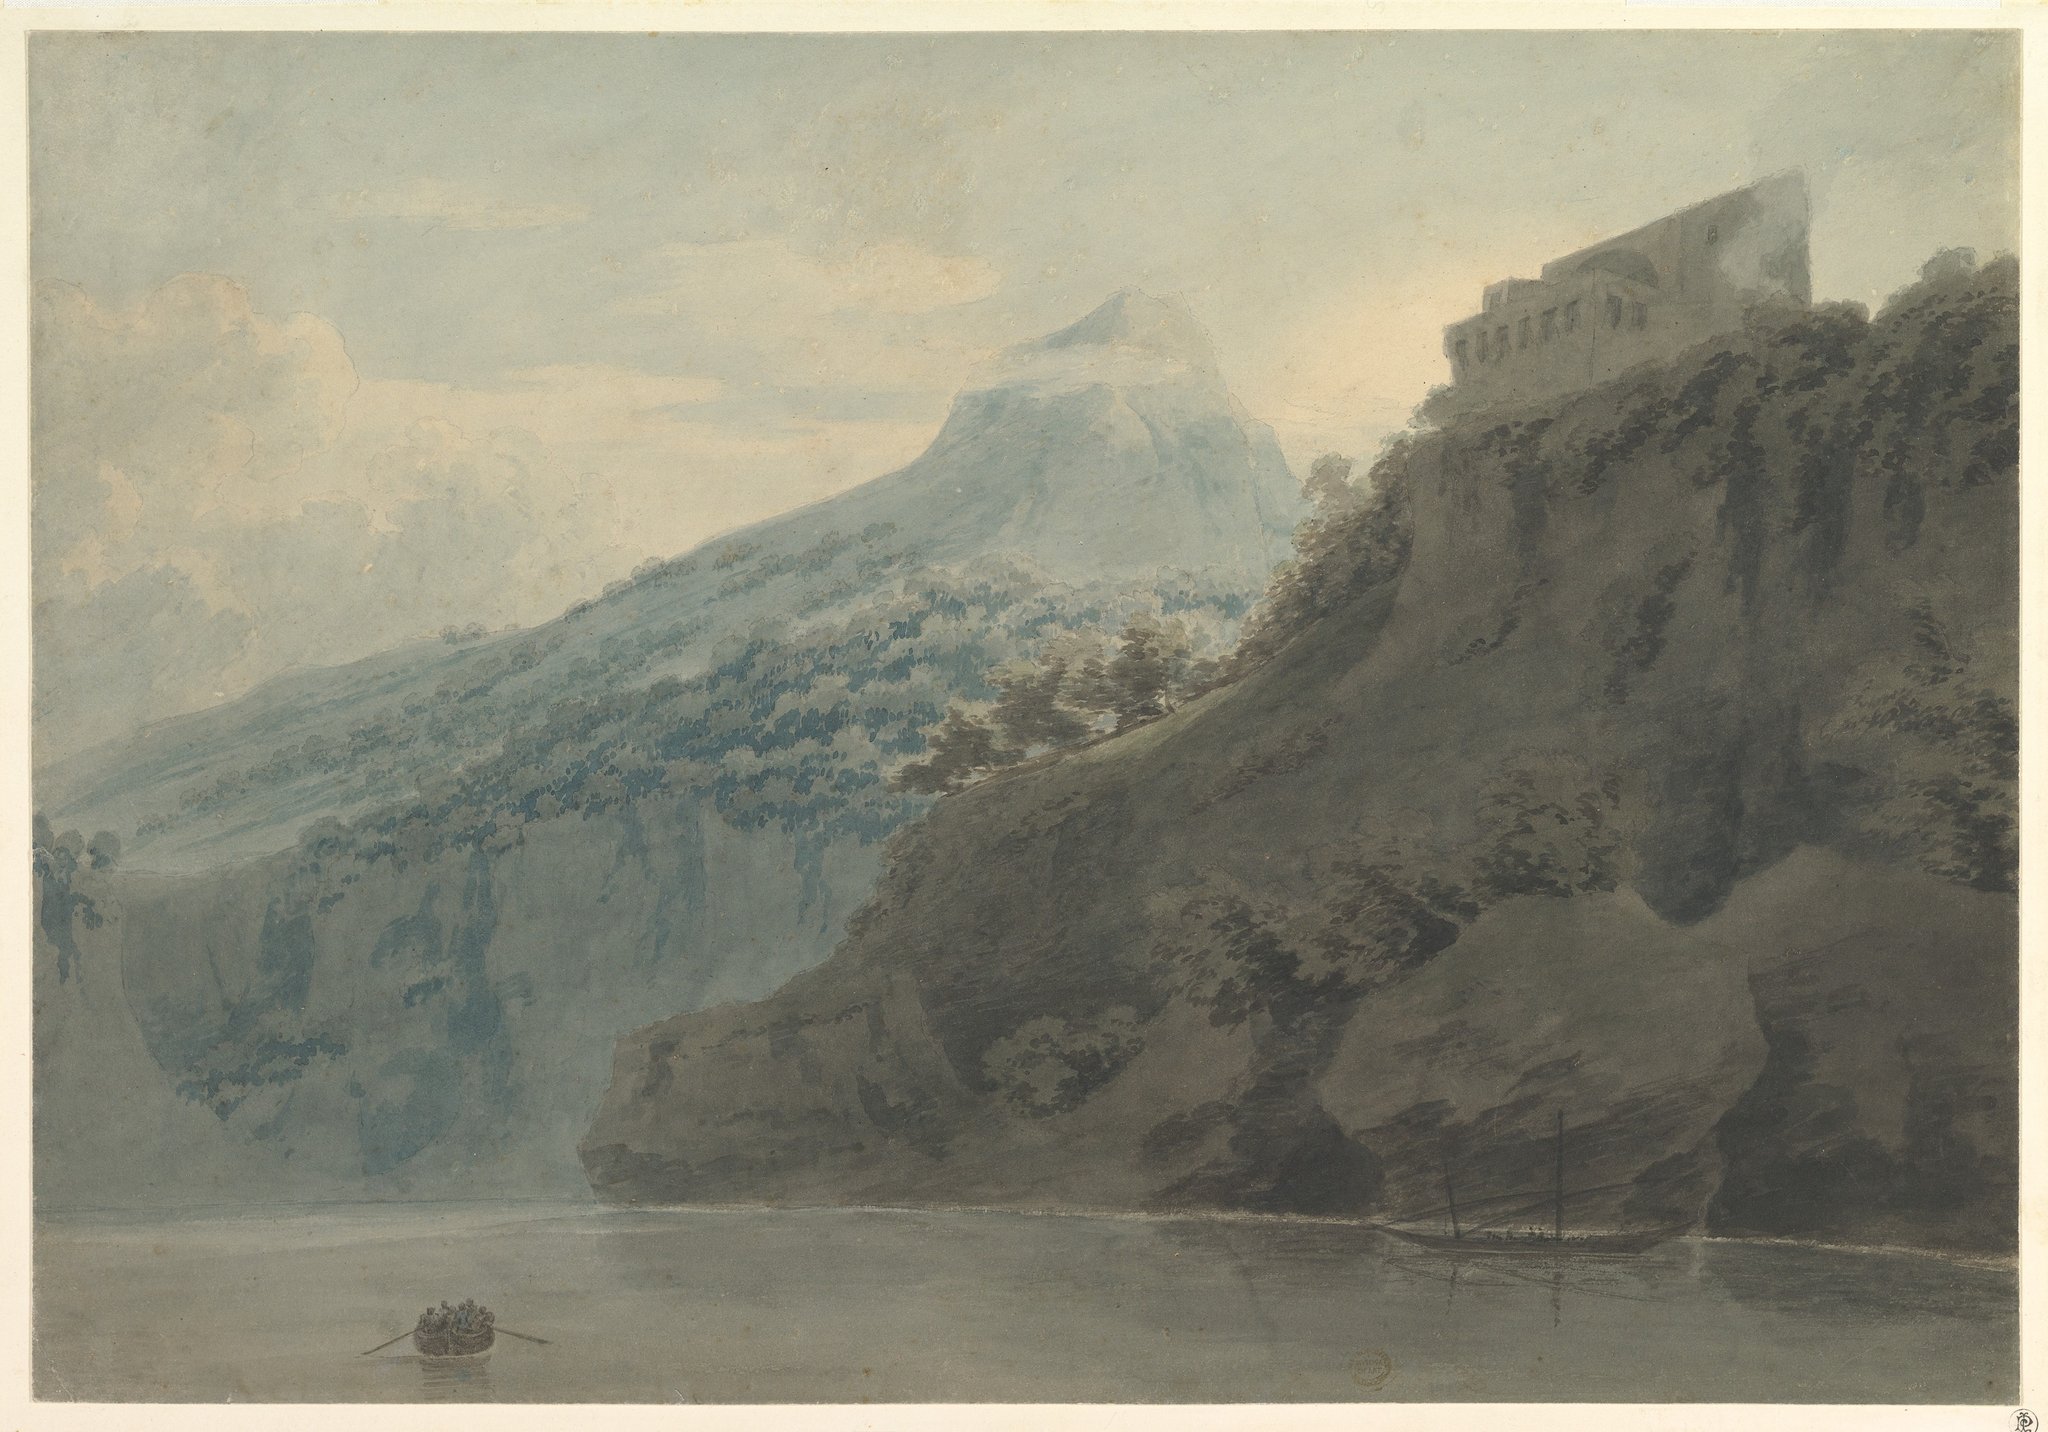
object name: drawing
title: On the Gulf of Salerno near Vietri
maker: john robert cozens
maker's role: artist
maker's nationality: british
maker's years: 1752-1797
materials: graphite, watercolor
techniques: brush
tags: lakes,mountains,boats